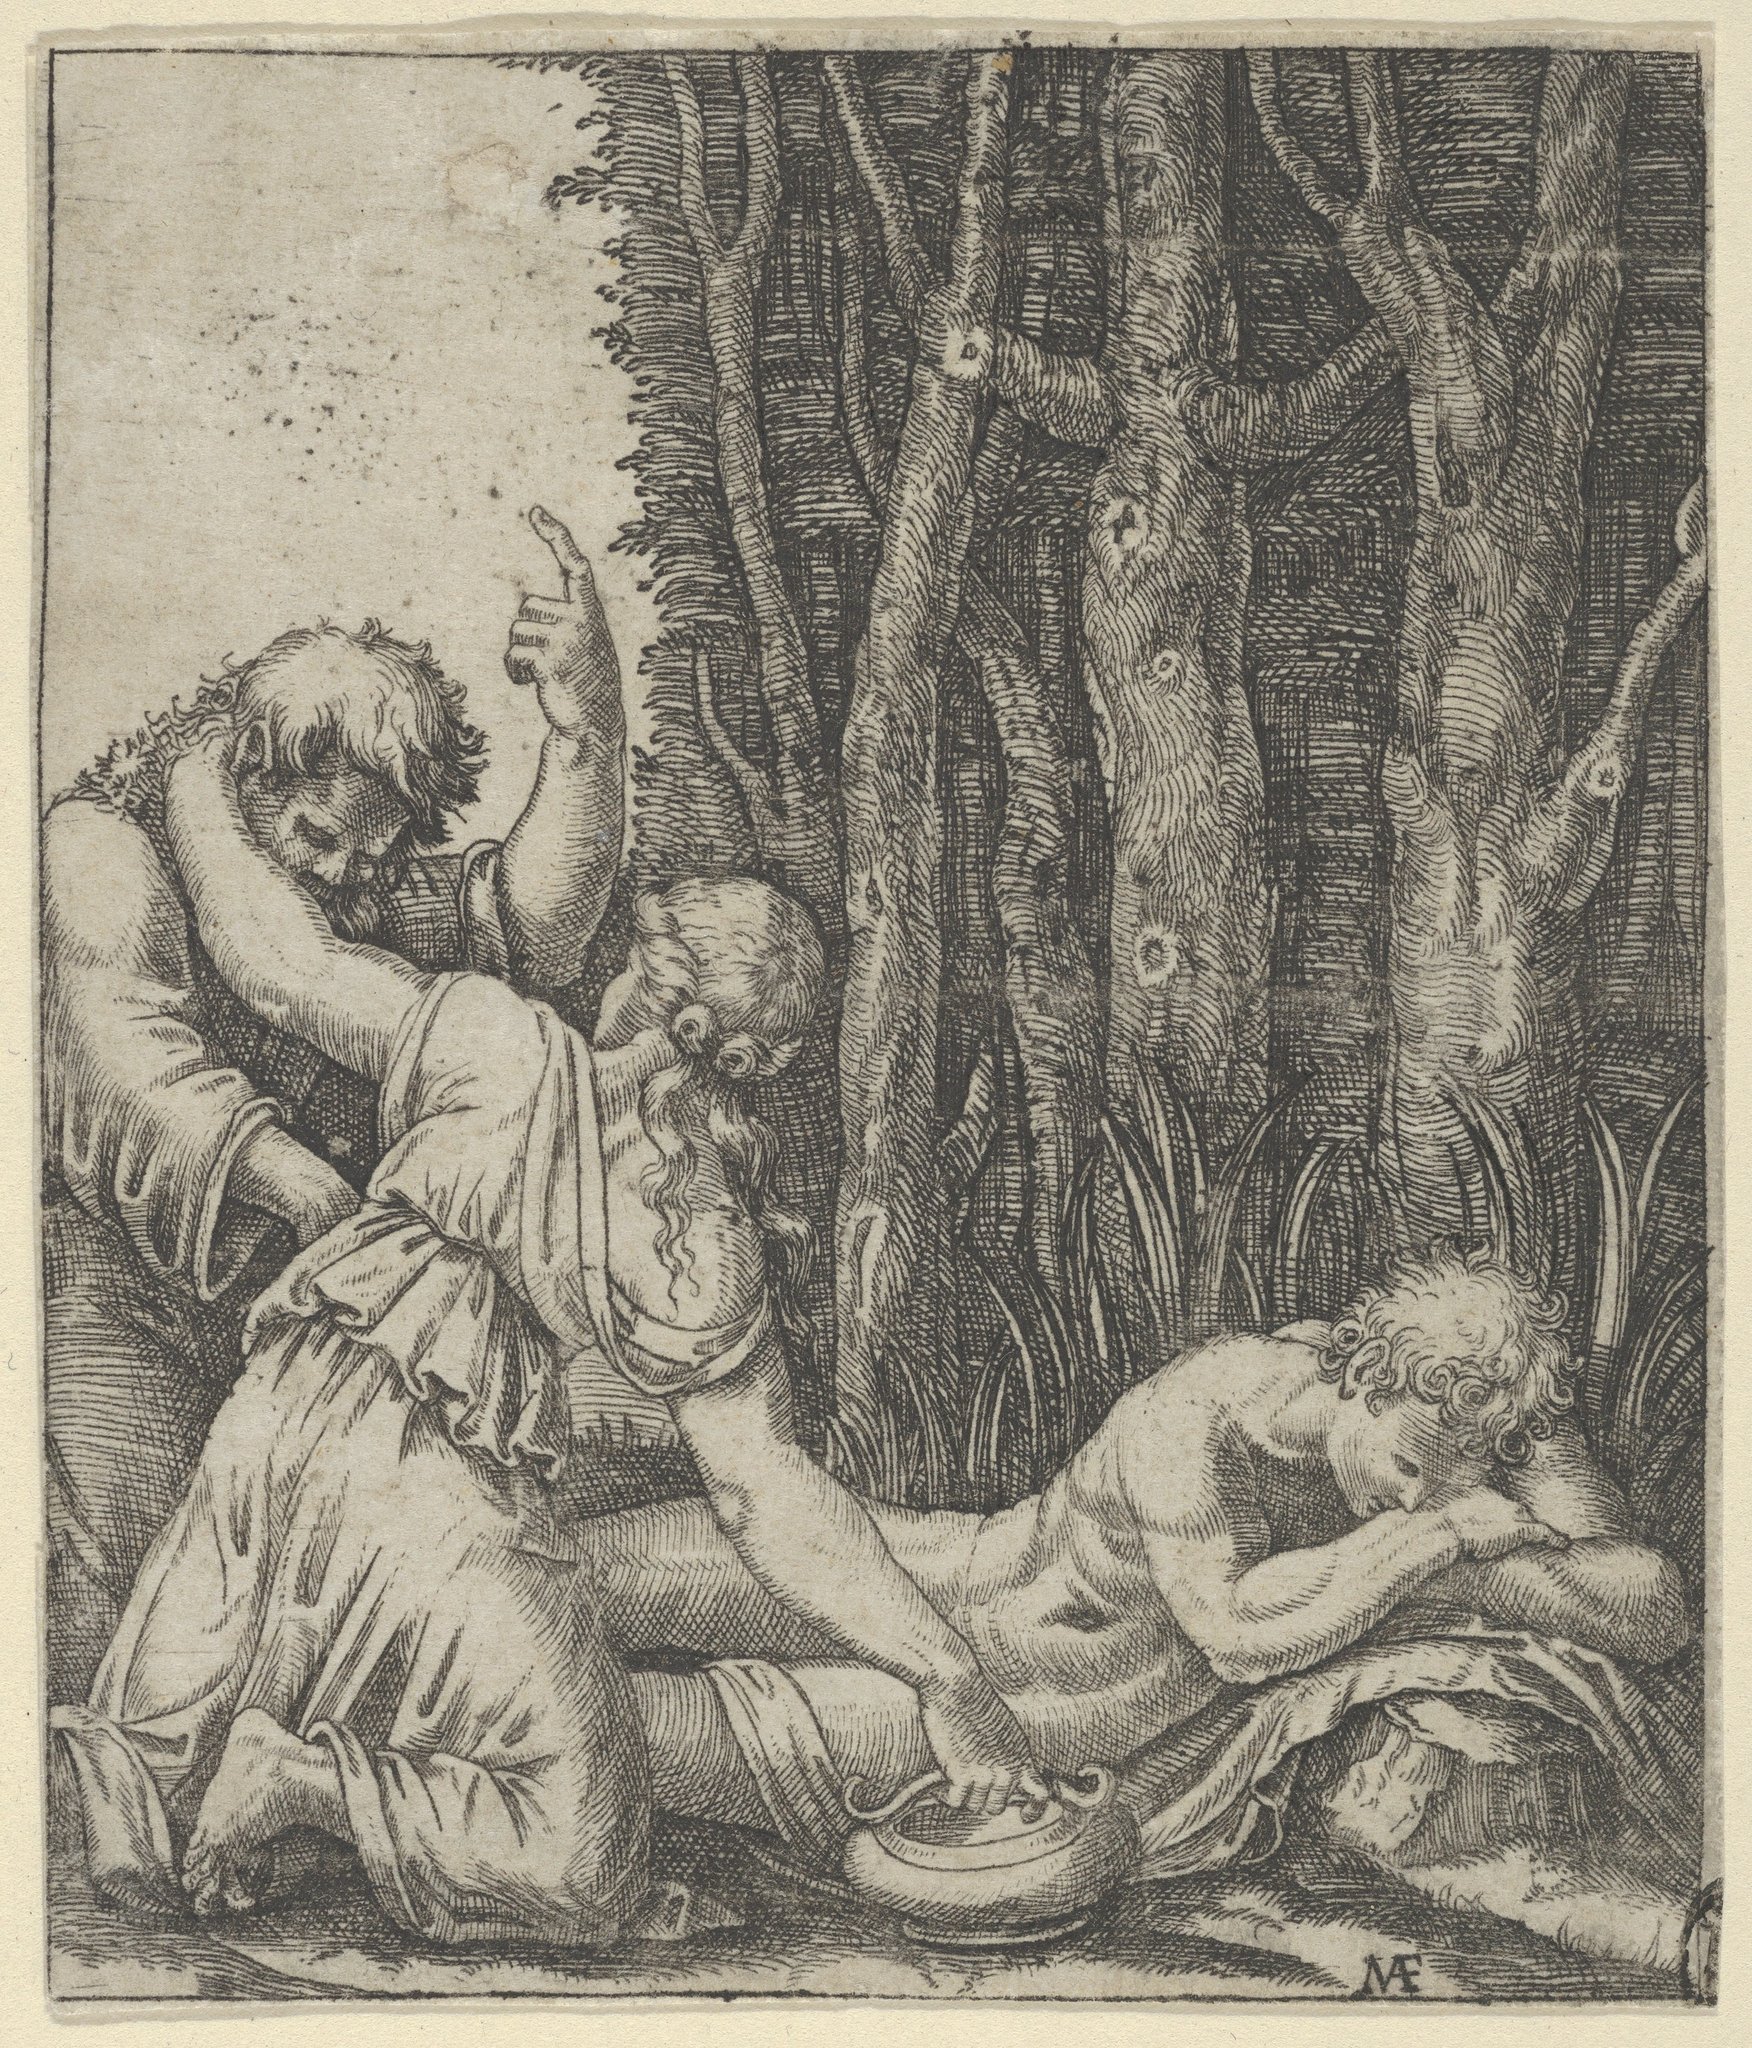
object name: print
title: Man sleeping at the edge of a wood with a woman knealing at his side with one hand on a pot and the other on the shoulder of an old man who gestures with left hand towards the sky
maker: marcantonio raimondi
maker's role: artist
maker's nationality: italian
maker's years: 1475-1534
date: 1500-1534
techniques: engraving, etching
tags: sleeping,men,women,trees